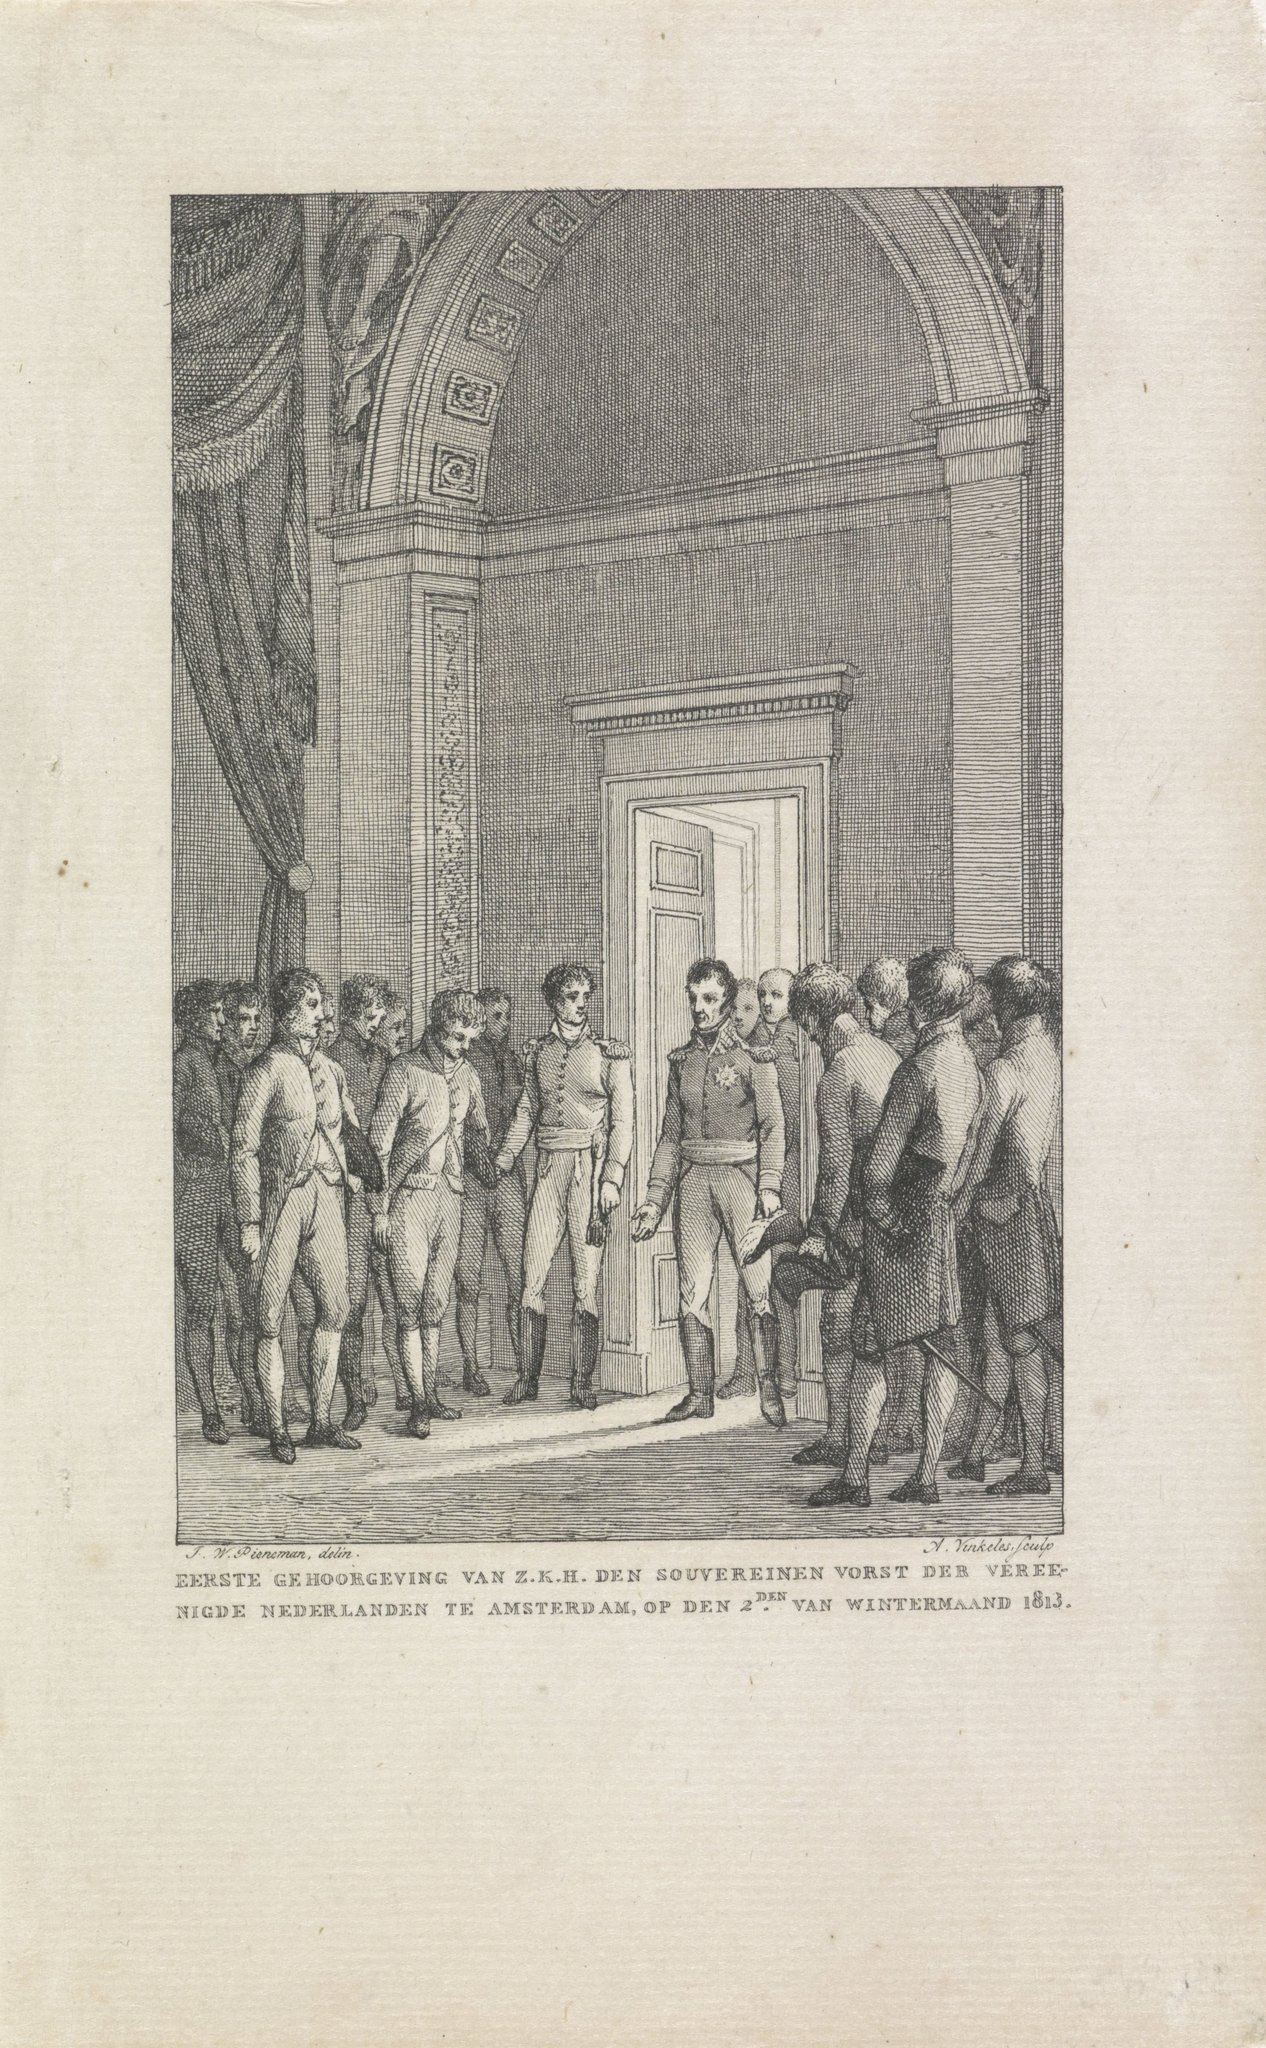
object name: print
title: Audiëntie van prins Willem Frederik te Amsterdam, 1813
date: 1814-1816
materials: paper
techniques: engraving, etching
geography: amsterdam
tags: the hague, berlin, william i of the netherlands, political meeting, propaganda meeting, amsterdam, landing of william frederick i (1813)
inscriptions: collector's mark: Lugt 2228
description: Eerste audiëntie van prins Willem Frederik als Souverein Vorst te Amsterdam op 2 december 1813. In het stadhuis ontmoet de prins vertegenwoordigers van de stad.